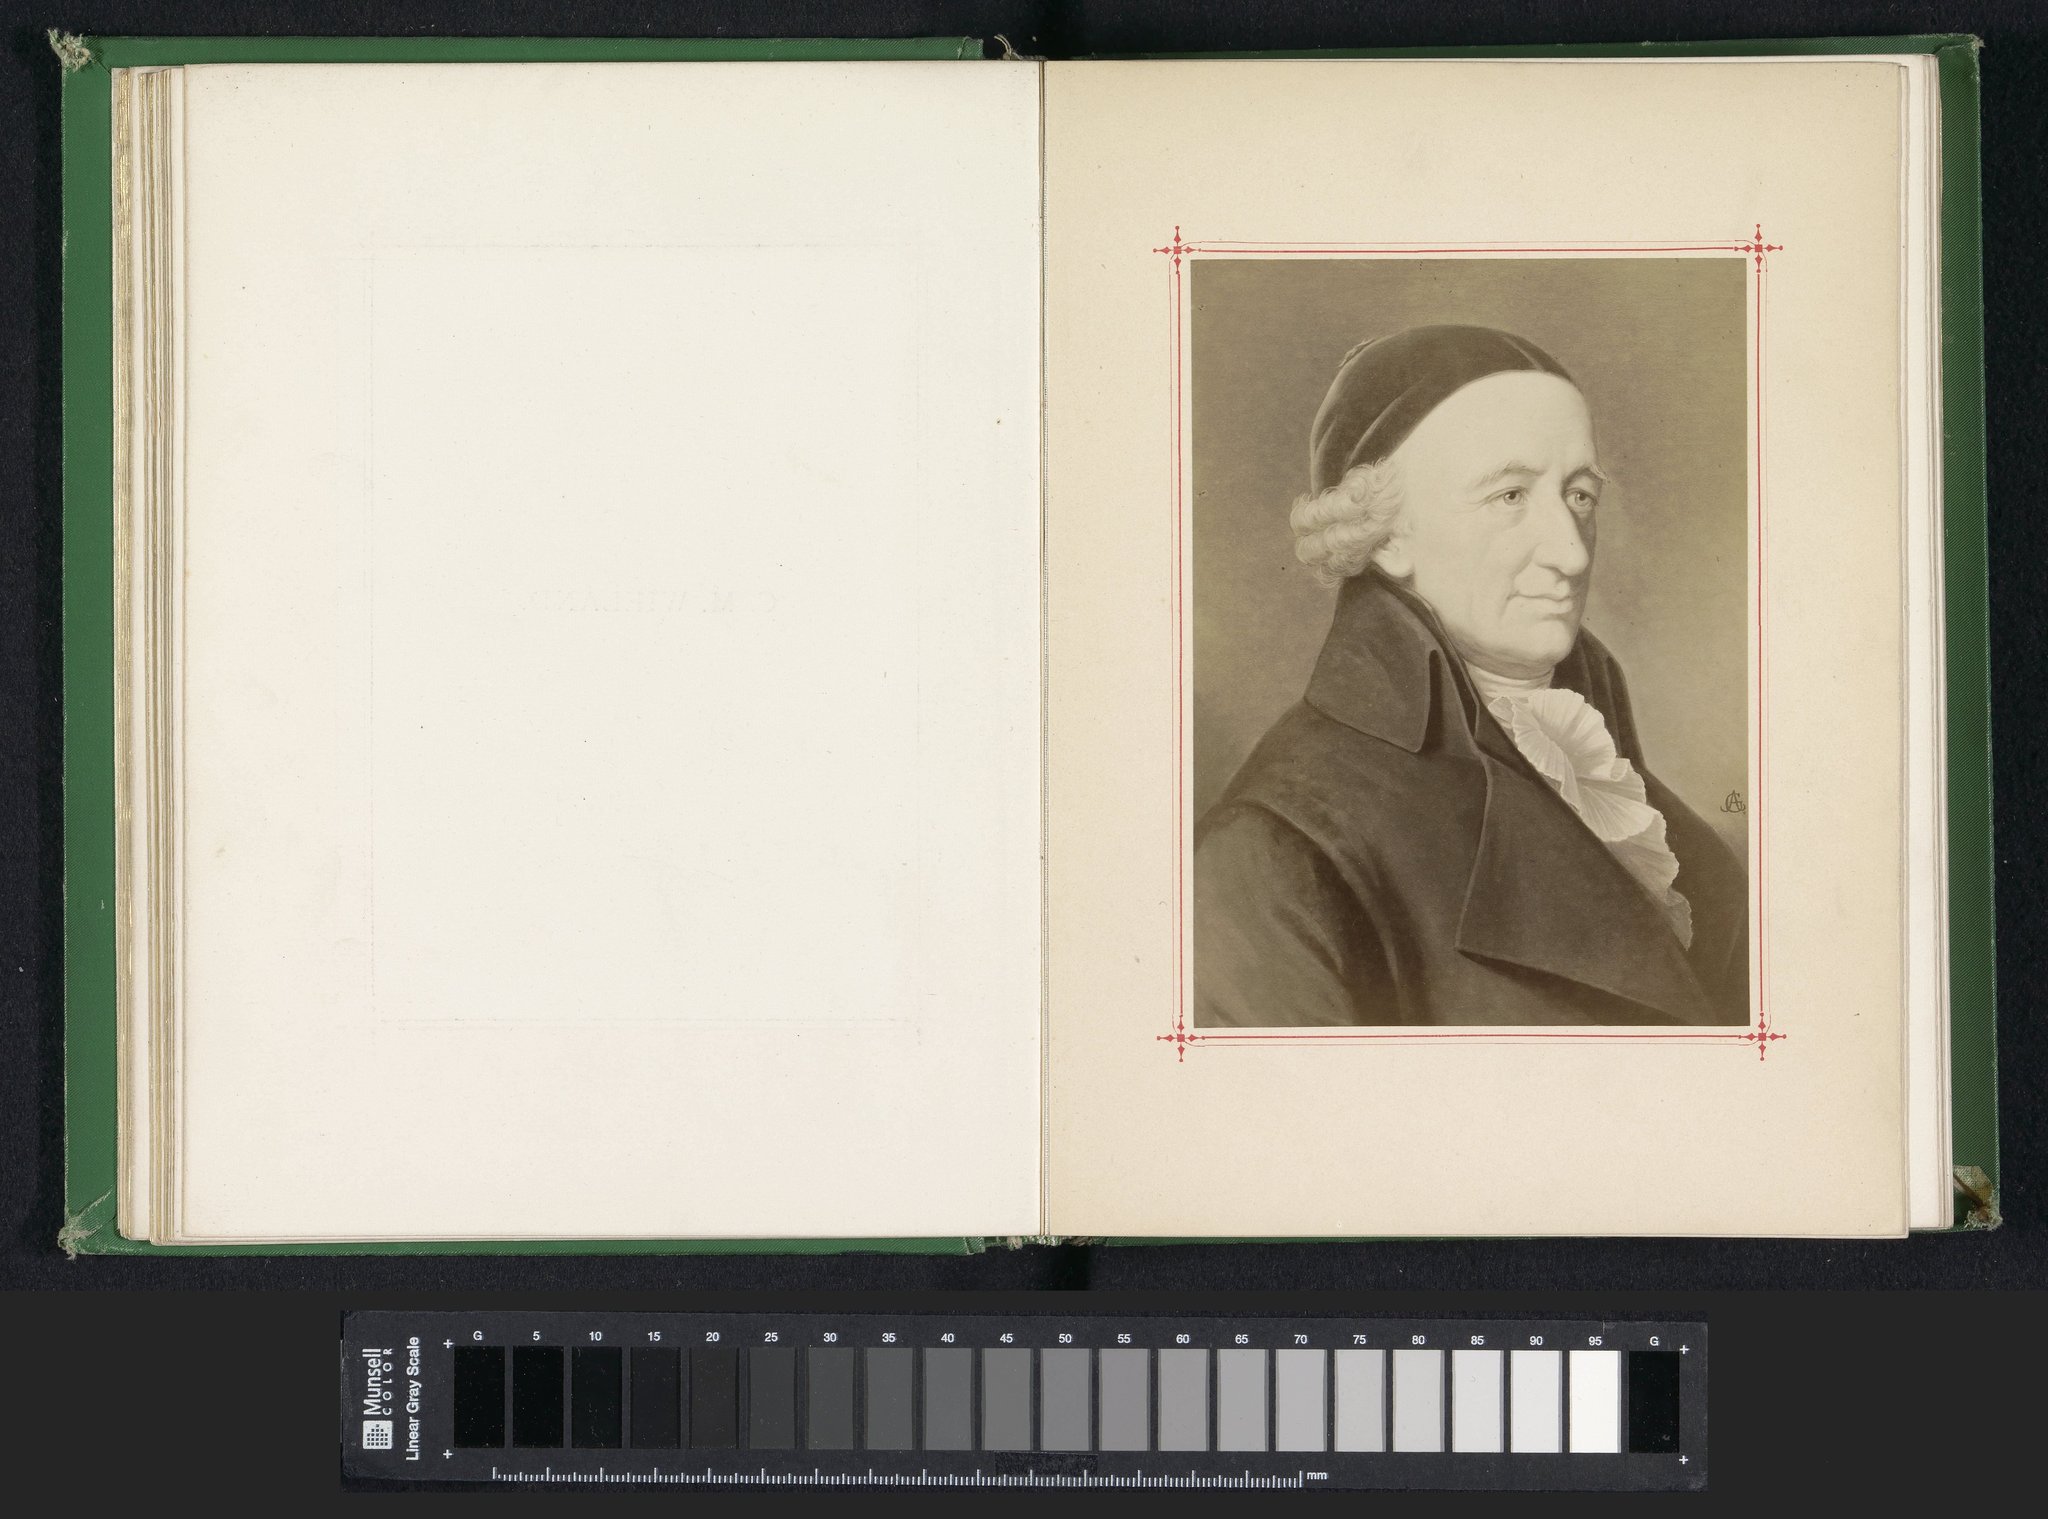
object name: reproduction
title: Fotoreproductie van een portret van Christoph Martin Wieland door vermoedelijk Albert Gräfle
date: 1868-1878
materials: photographic support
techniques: albumen print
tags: publisher, christoph martin wieland, writer, poet, author